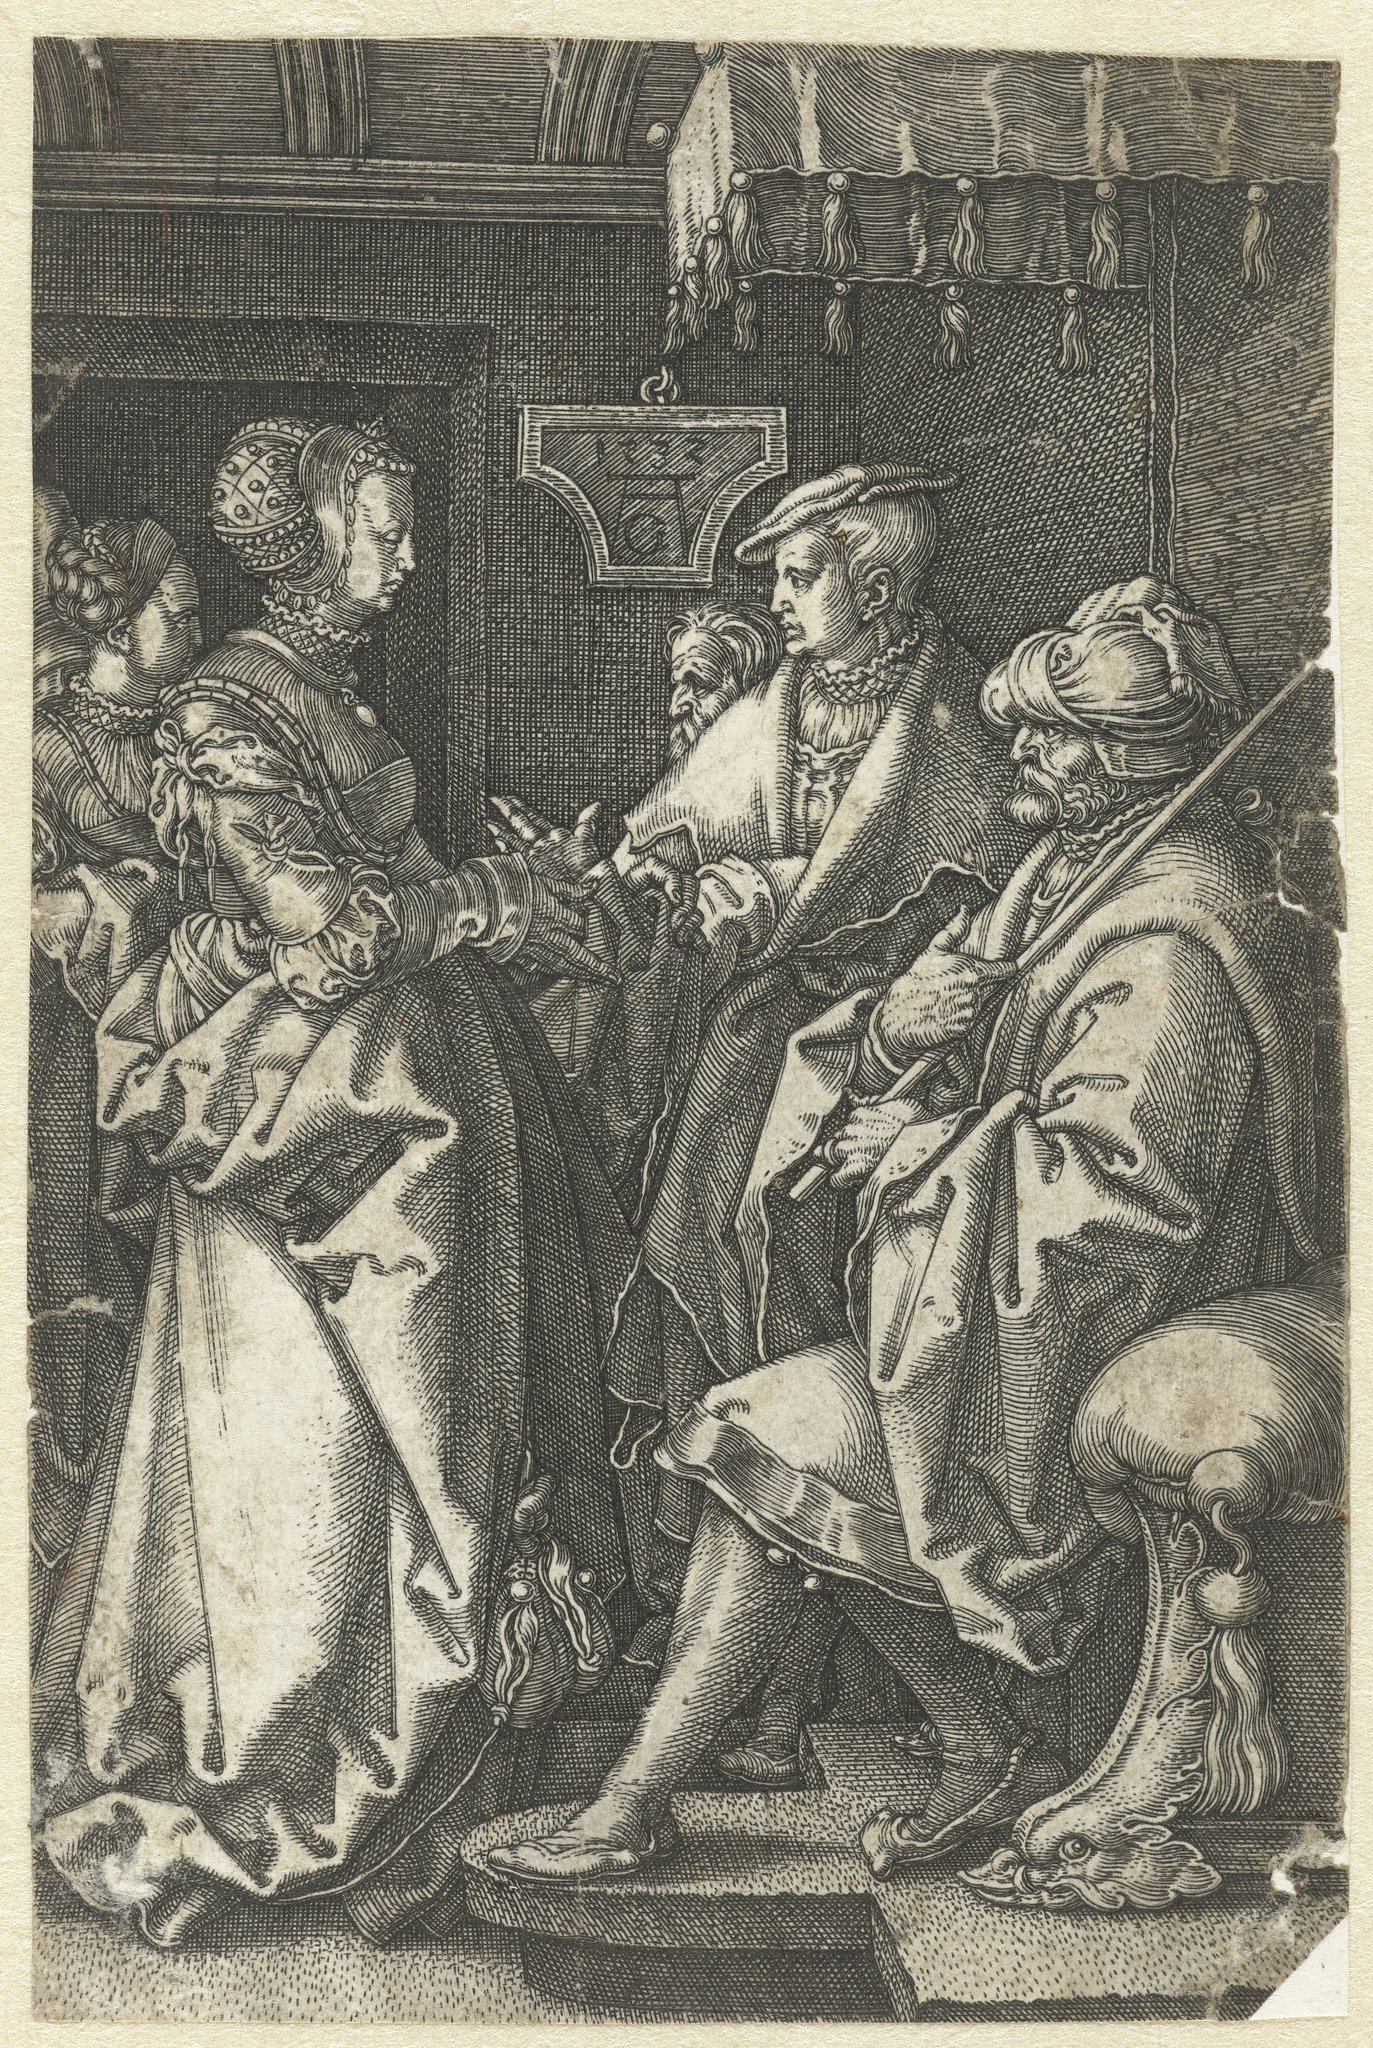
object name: print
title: Geschiedenis van Jozef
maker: heinrich aldegrever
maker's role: draughtsman, print maker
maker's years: 1502-1561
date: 1532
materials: paper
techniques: engraving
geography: germany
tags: potiphar's wife before her husband: she accuses joseph of trying to violate her, using the cloak as evidence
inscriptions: collector's mark: ‘Hinloopen’ Lugt 11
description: De vrouw van Potifar toont aan haar man de mantel van Jozef. Zij beschuldig Jozef ervan haar te willen verleiden. Derde prent van drie met het verhaal van Jozef.